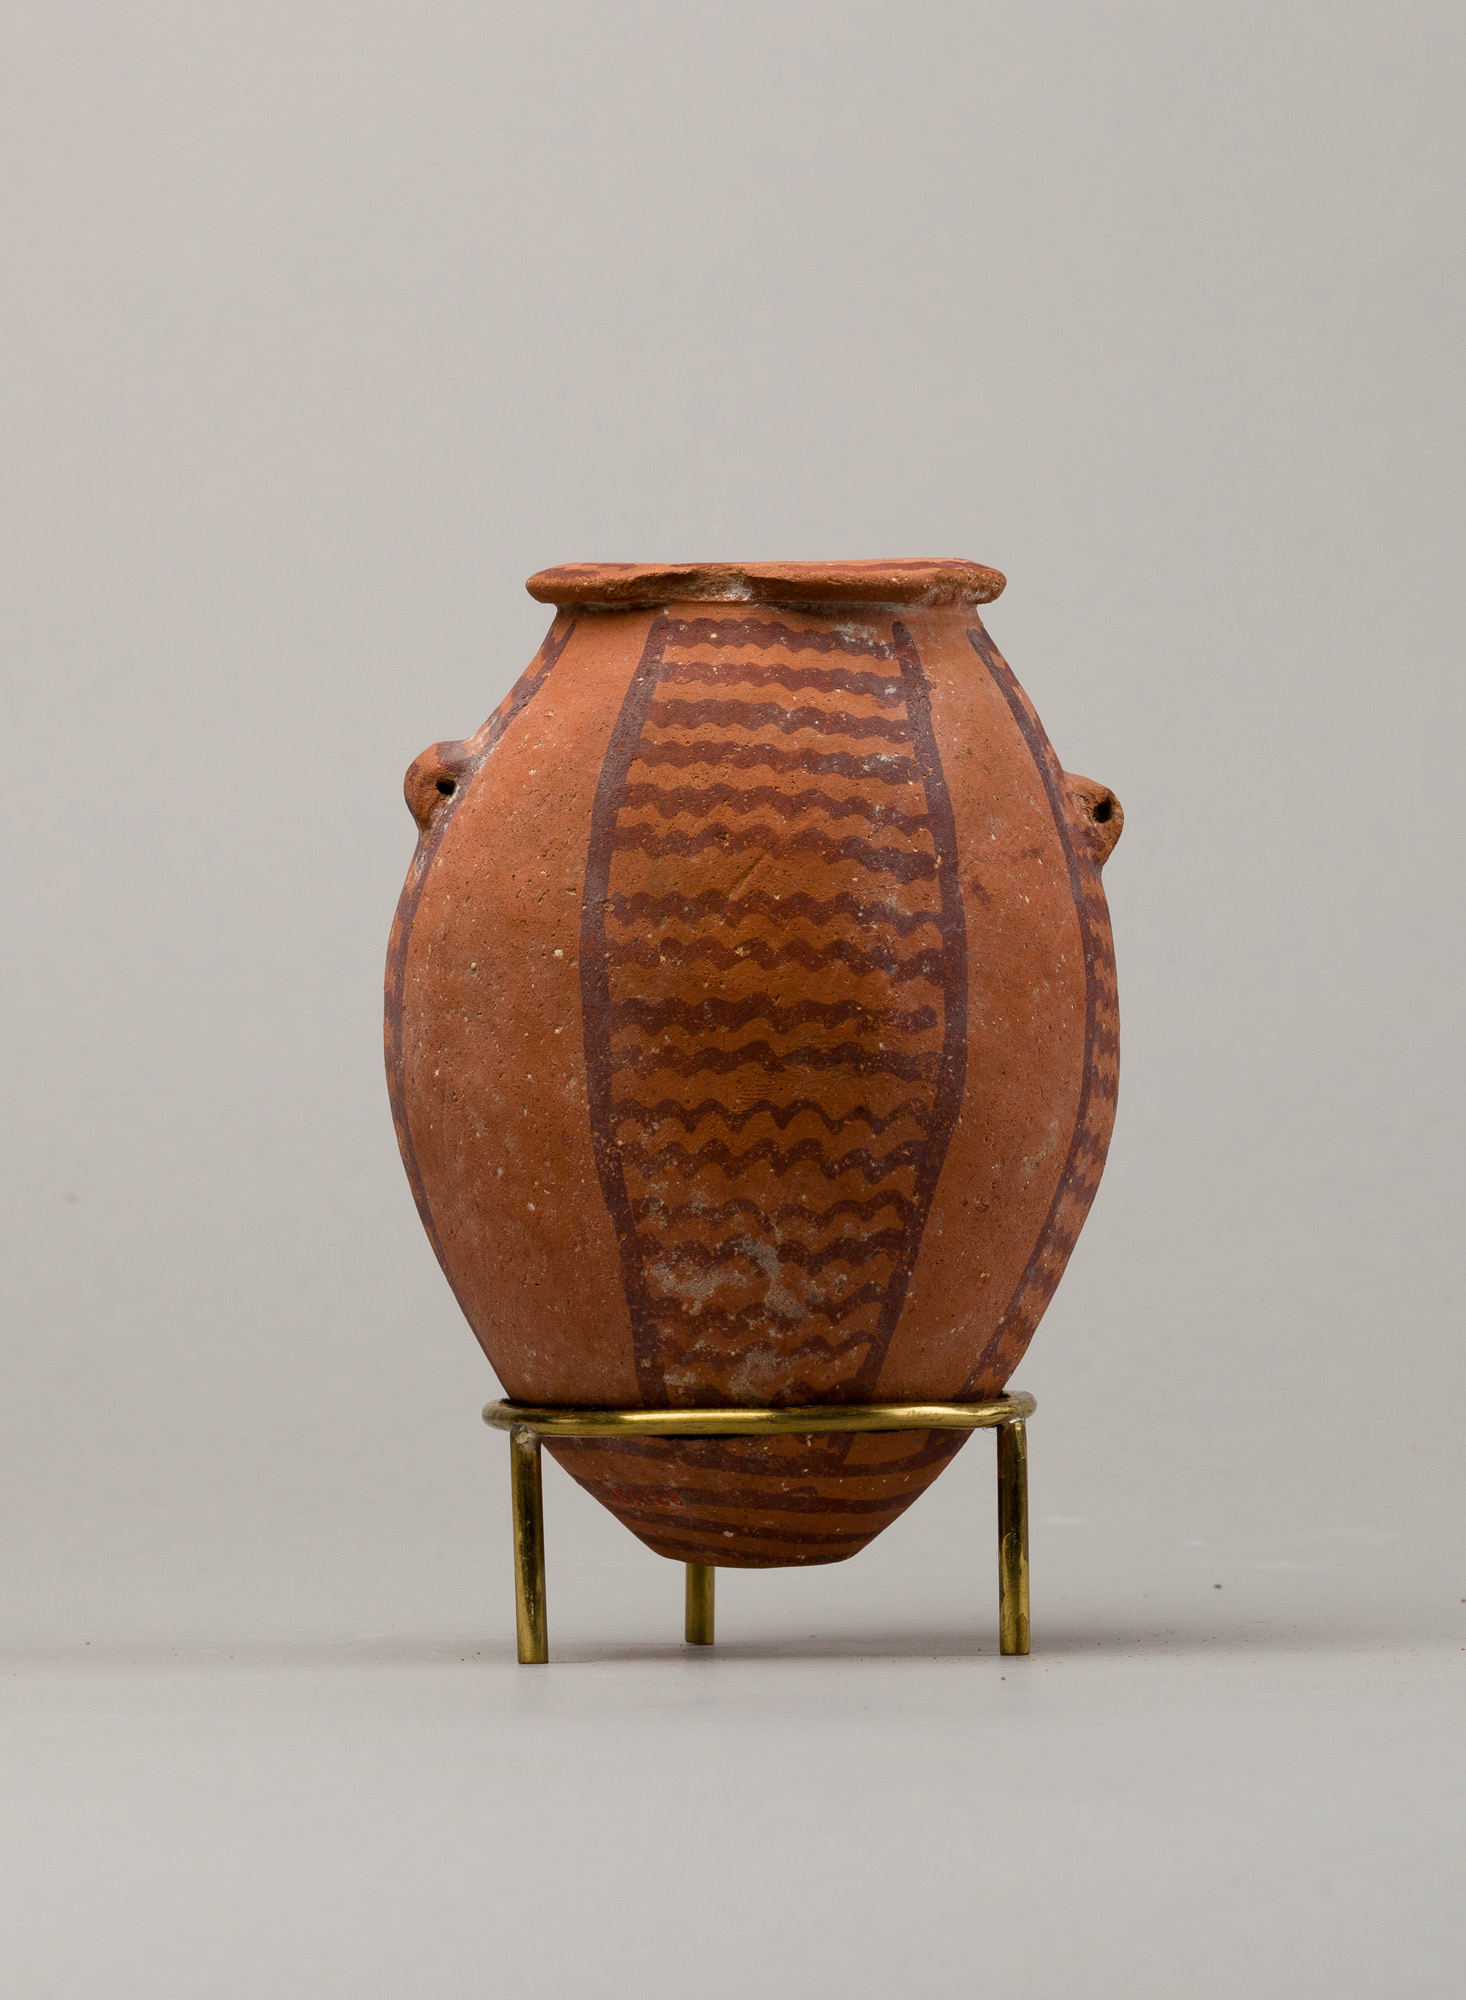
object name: jar, decorated ware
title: Decorated ware jar with lug handles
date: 3850-2960 BCE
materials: paint, pottery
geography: egypt